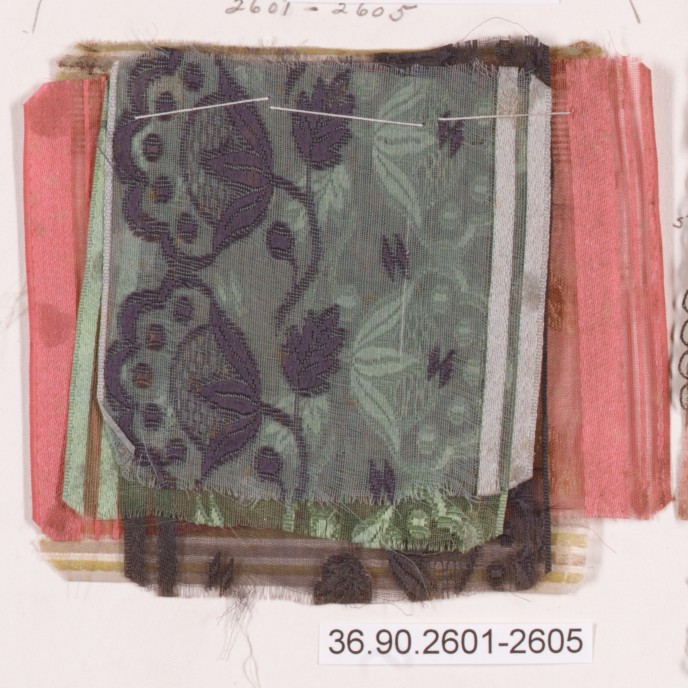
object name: ribbon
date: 1801-1900